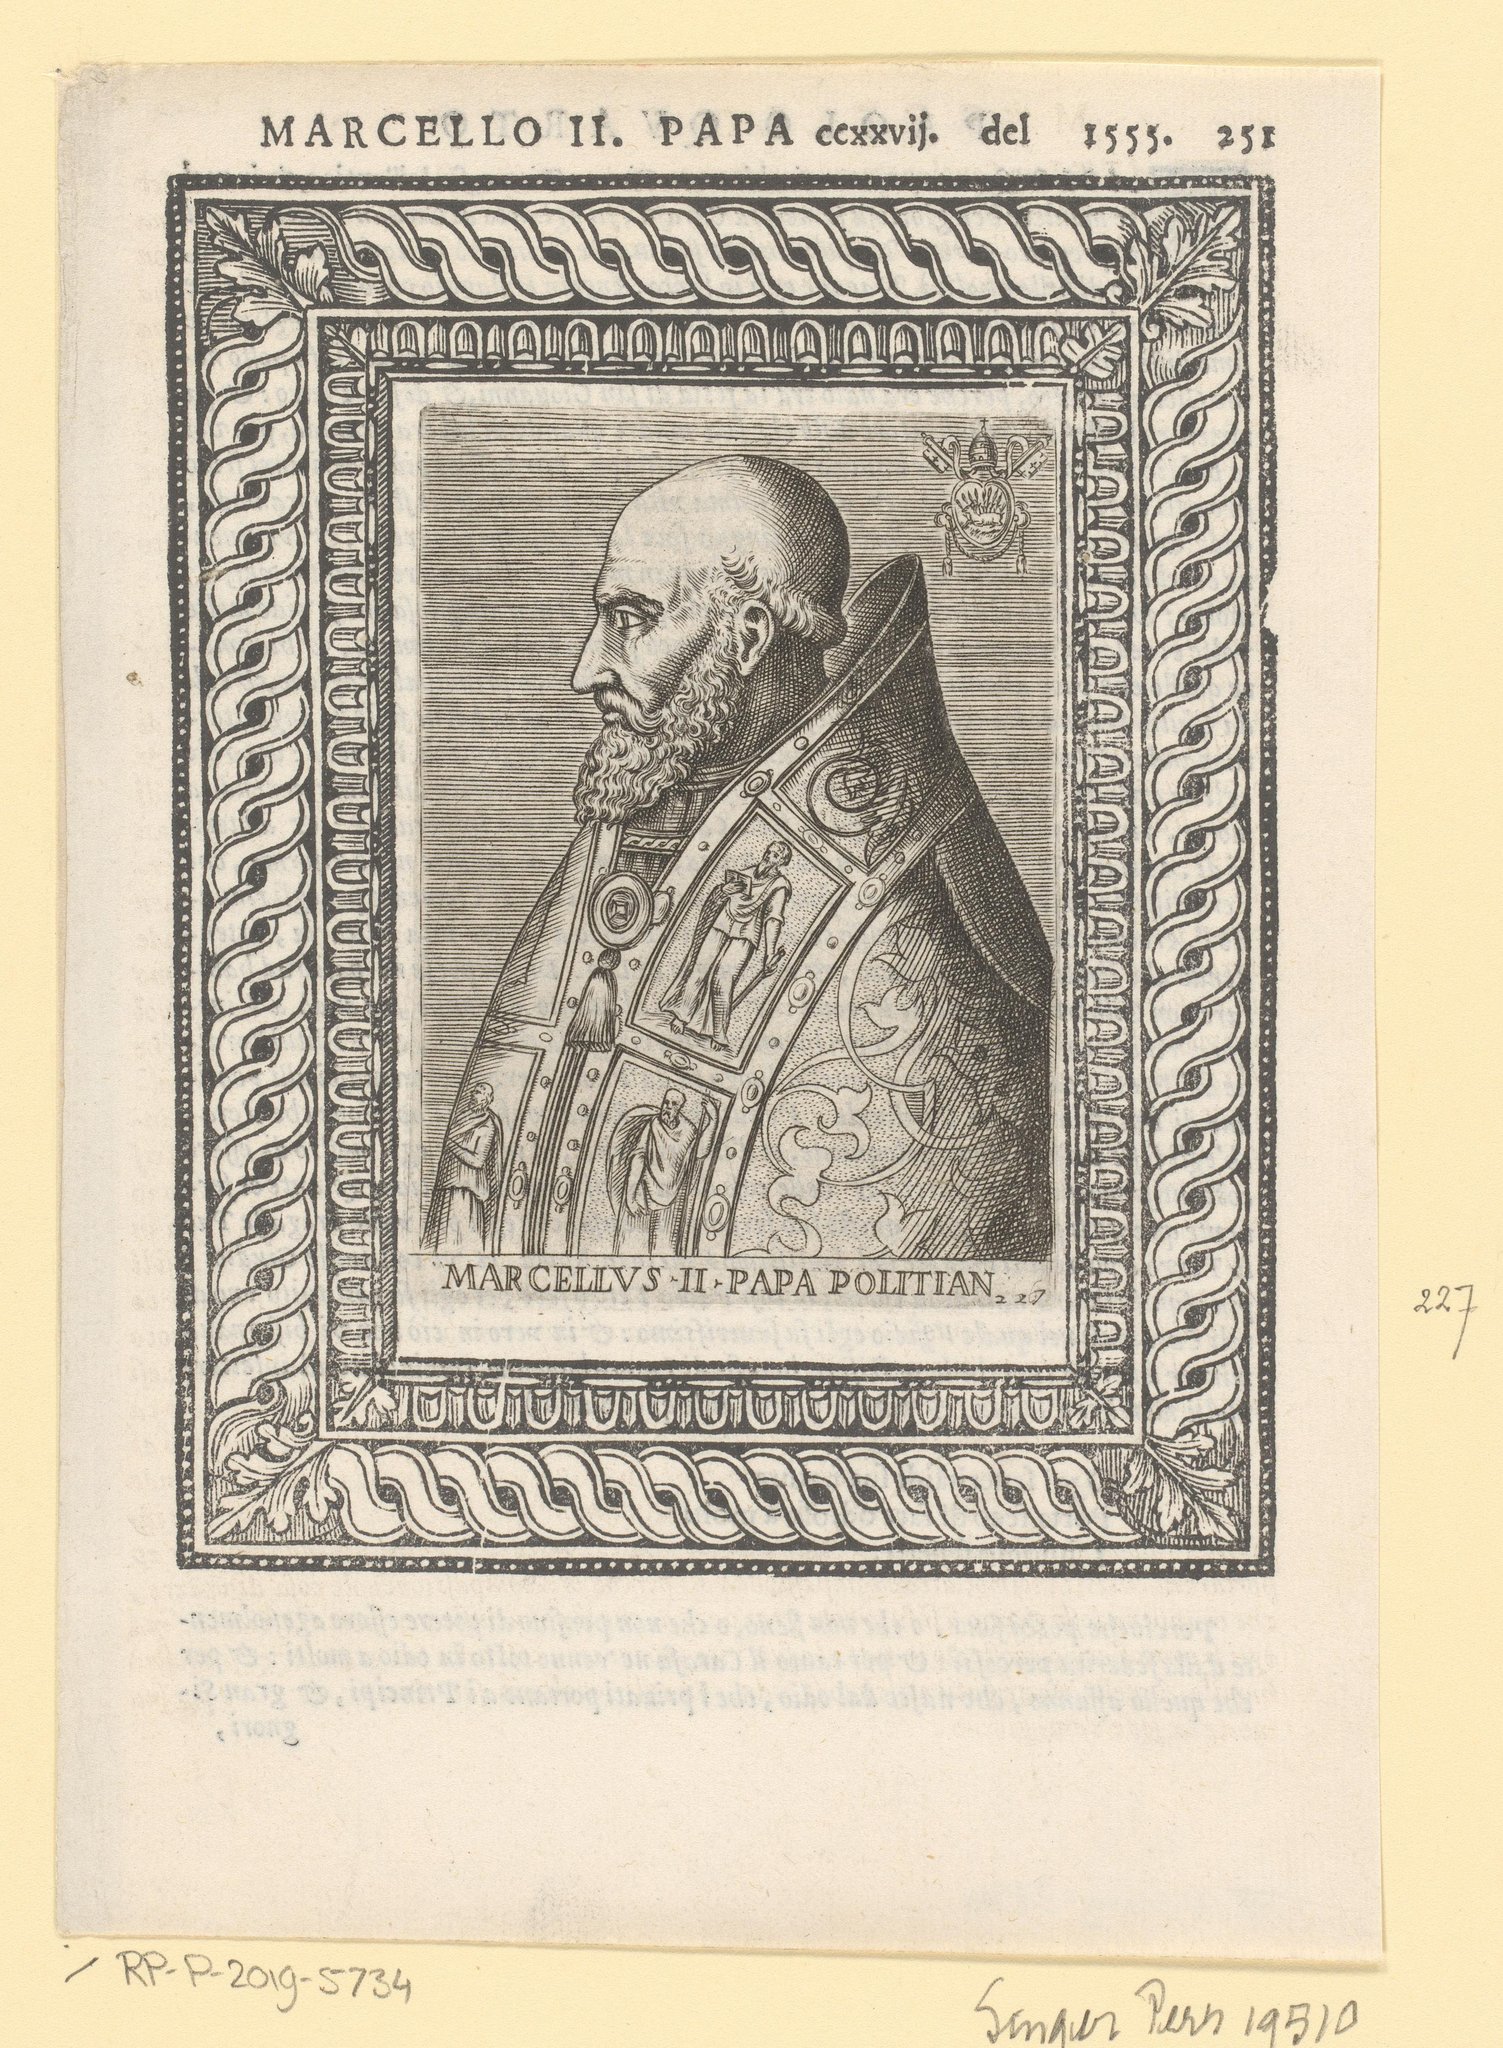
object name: book illustration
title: Portret van paus Marcellus II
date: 1587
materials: paper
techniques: engraving, letterpress printing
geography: rome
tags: historical persons, pope, armorial bearing, heraldry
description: Prent uit: Ciccarelli, Antonio. Le vite de Pontefici di Antonio Ciccarelli (...). Rome: Domenico Basa, 1587. Prent voor het eerst verschenen in: Cavalieri, Giovanni Battista de'. Pontificum romanorum effigies (...). Rome: Domenico Basa en Francesco Zanetti, 1580. Prent ook gebruikt in latere publicaties.